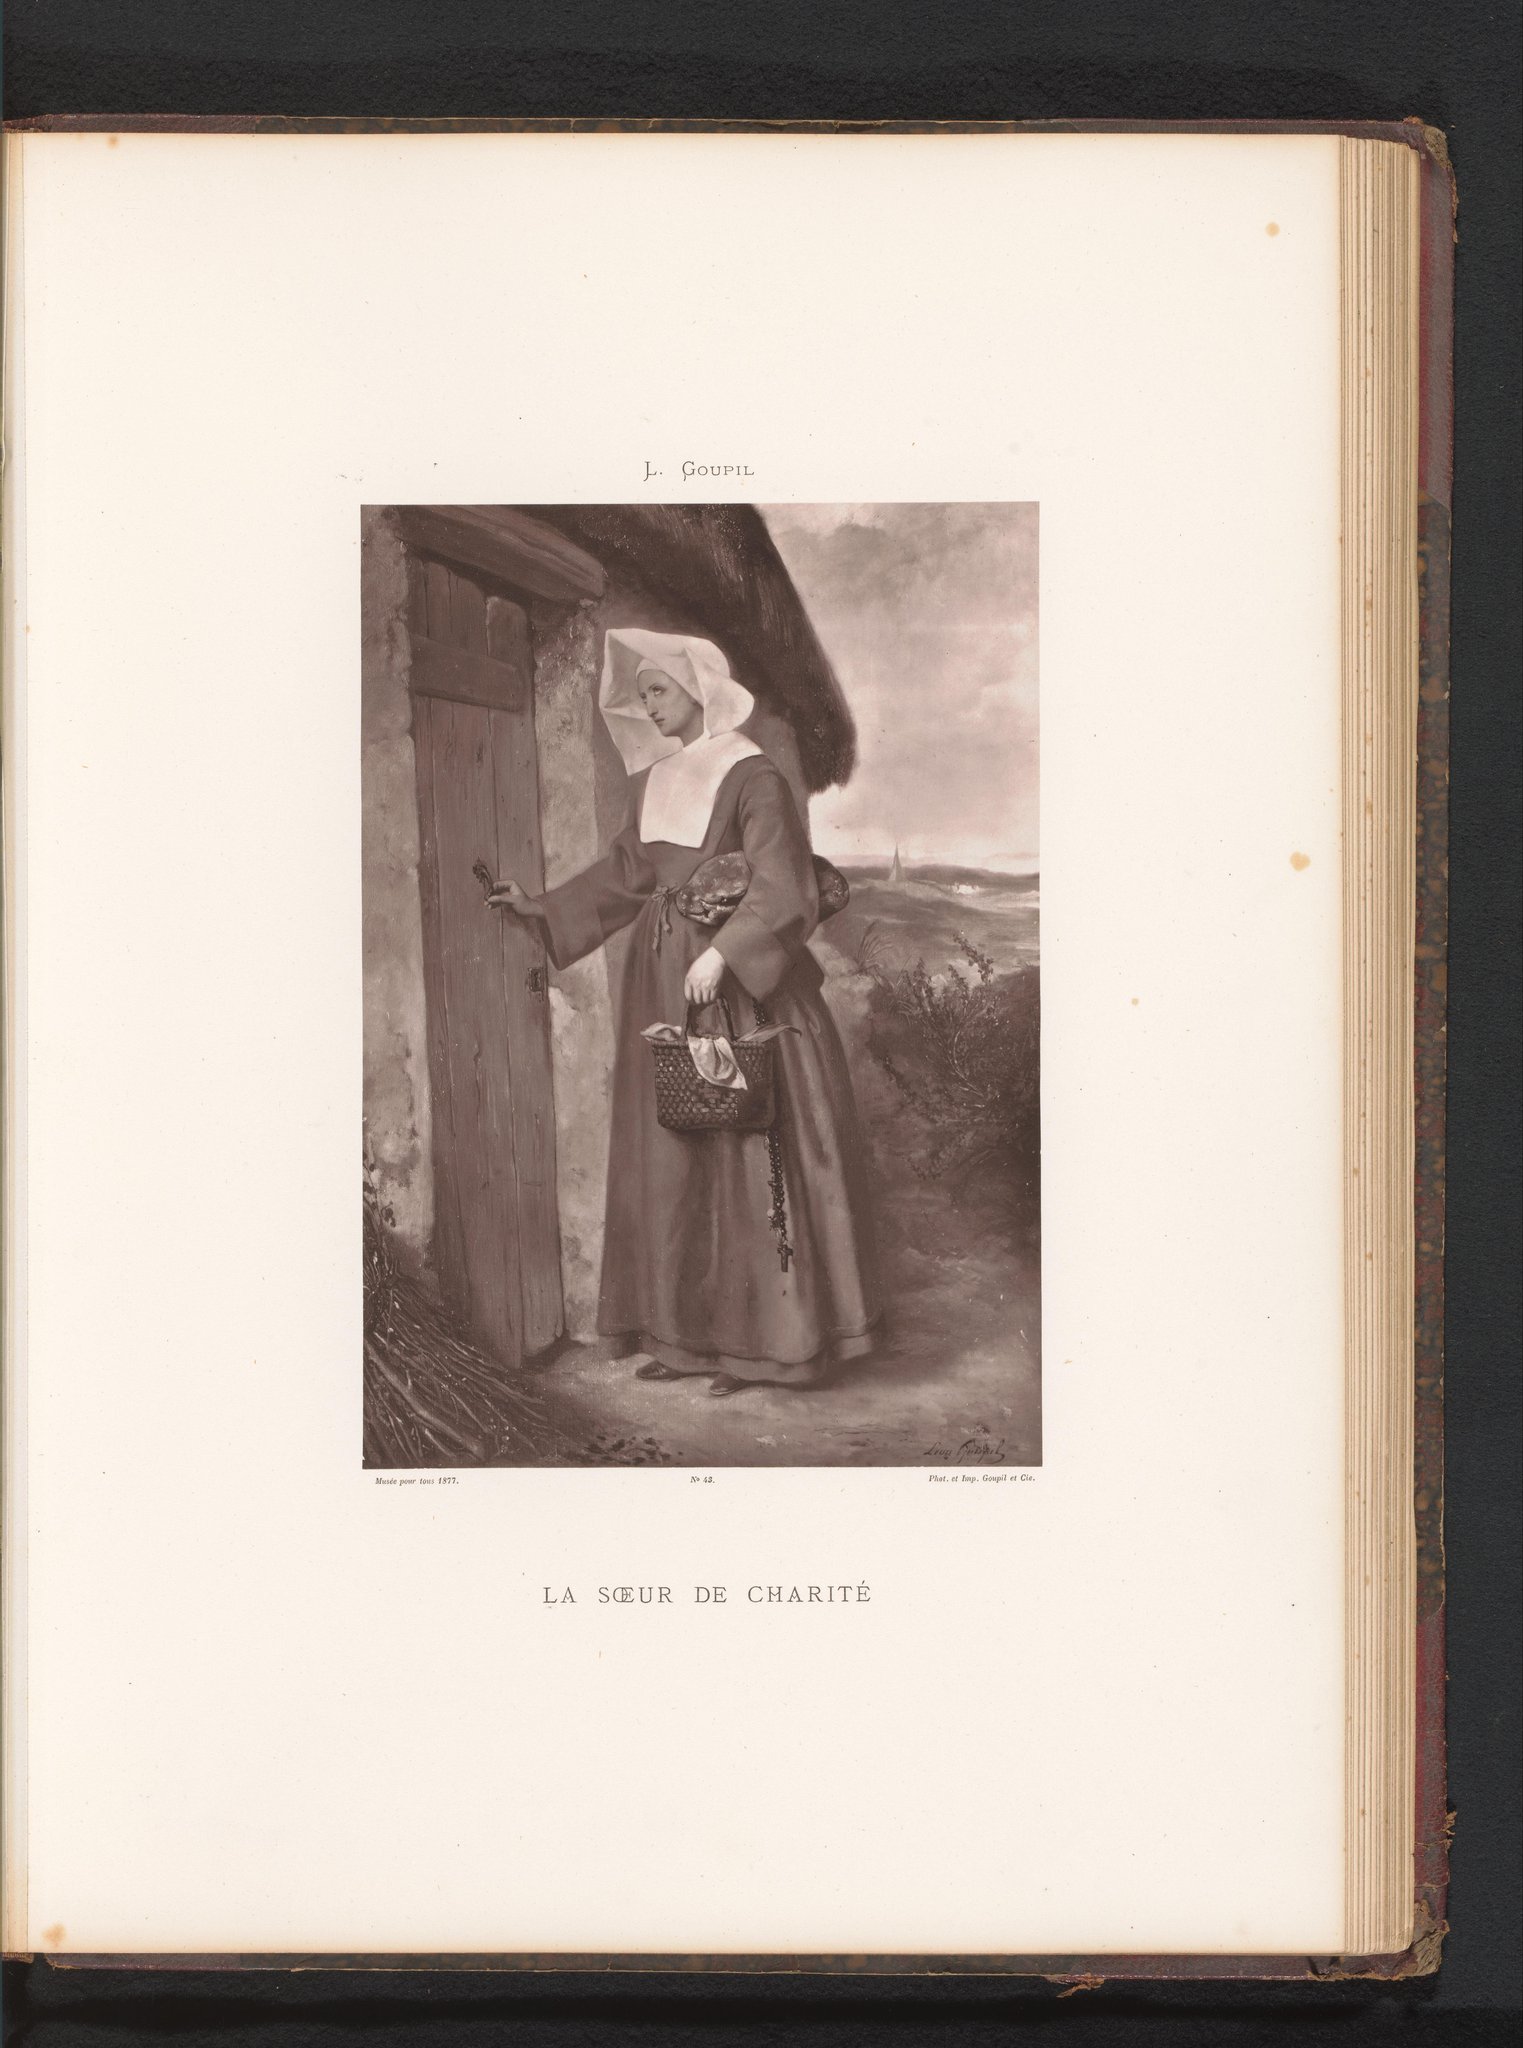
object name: photomechanical print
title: Reproductie van een schilderij van een zuster van de naastenliefde door Léon-Lucien Goupil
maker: léon-lucien goupil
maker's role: painter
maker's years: 1834-1890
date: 1872-1879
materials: paper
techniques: woodburytype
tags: charity, 'caritas'; 'carità' (ripa) ~ one of the three theological virtues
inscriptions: inscription: ‘Musée pour tous 1877/ No 43’